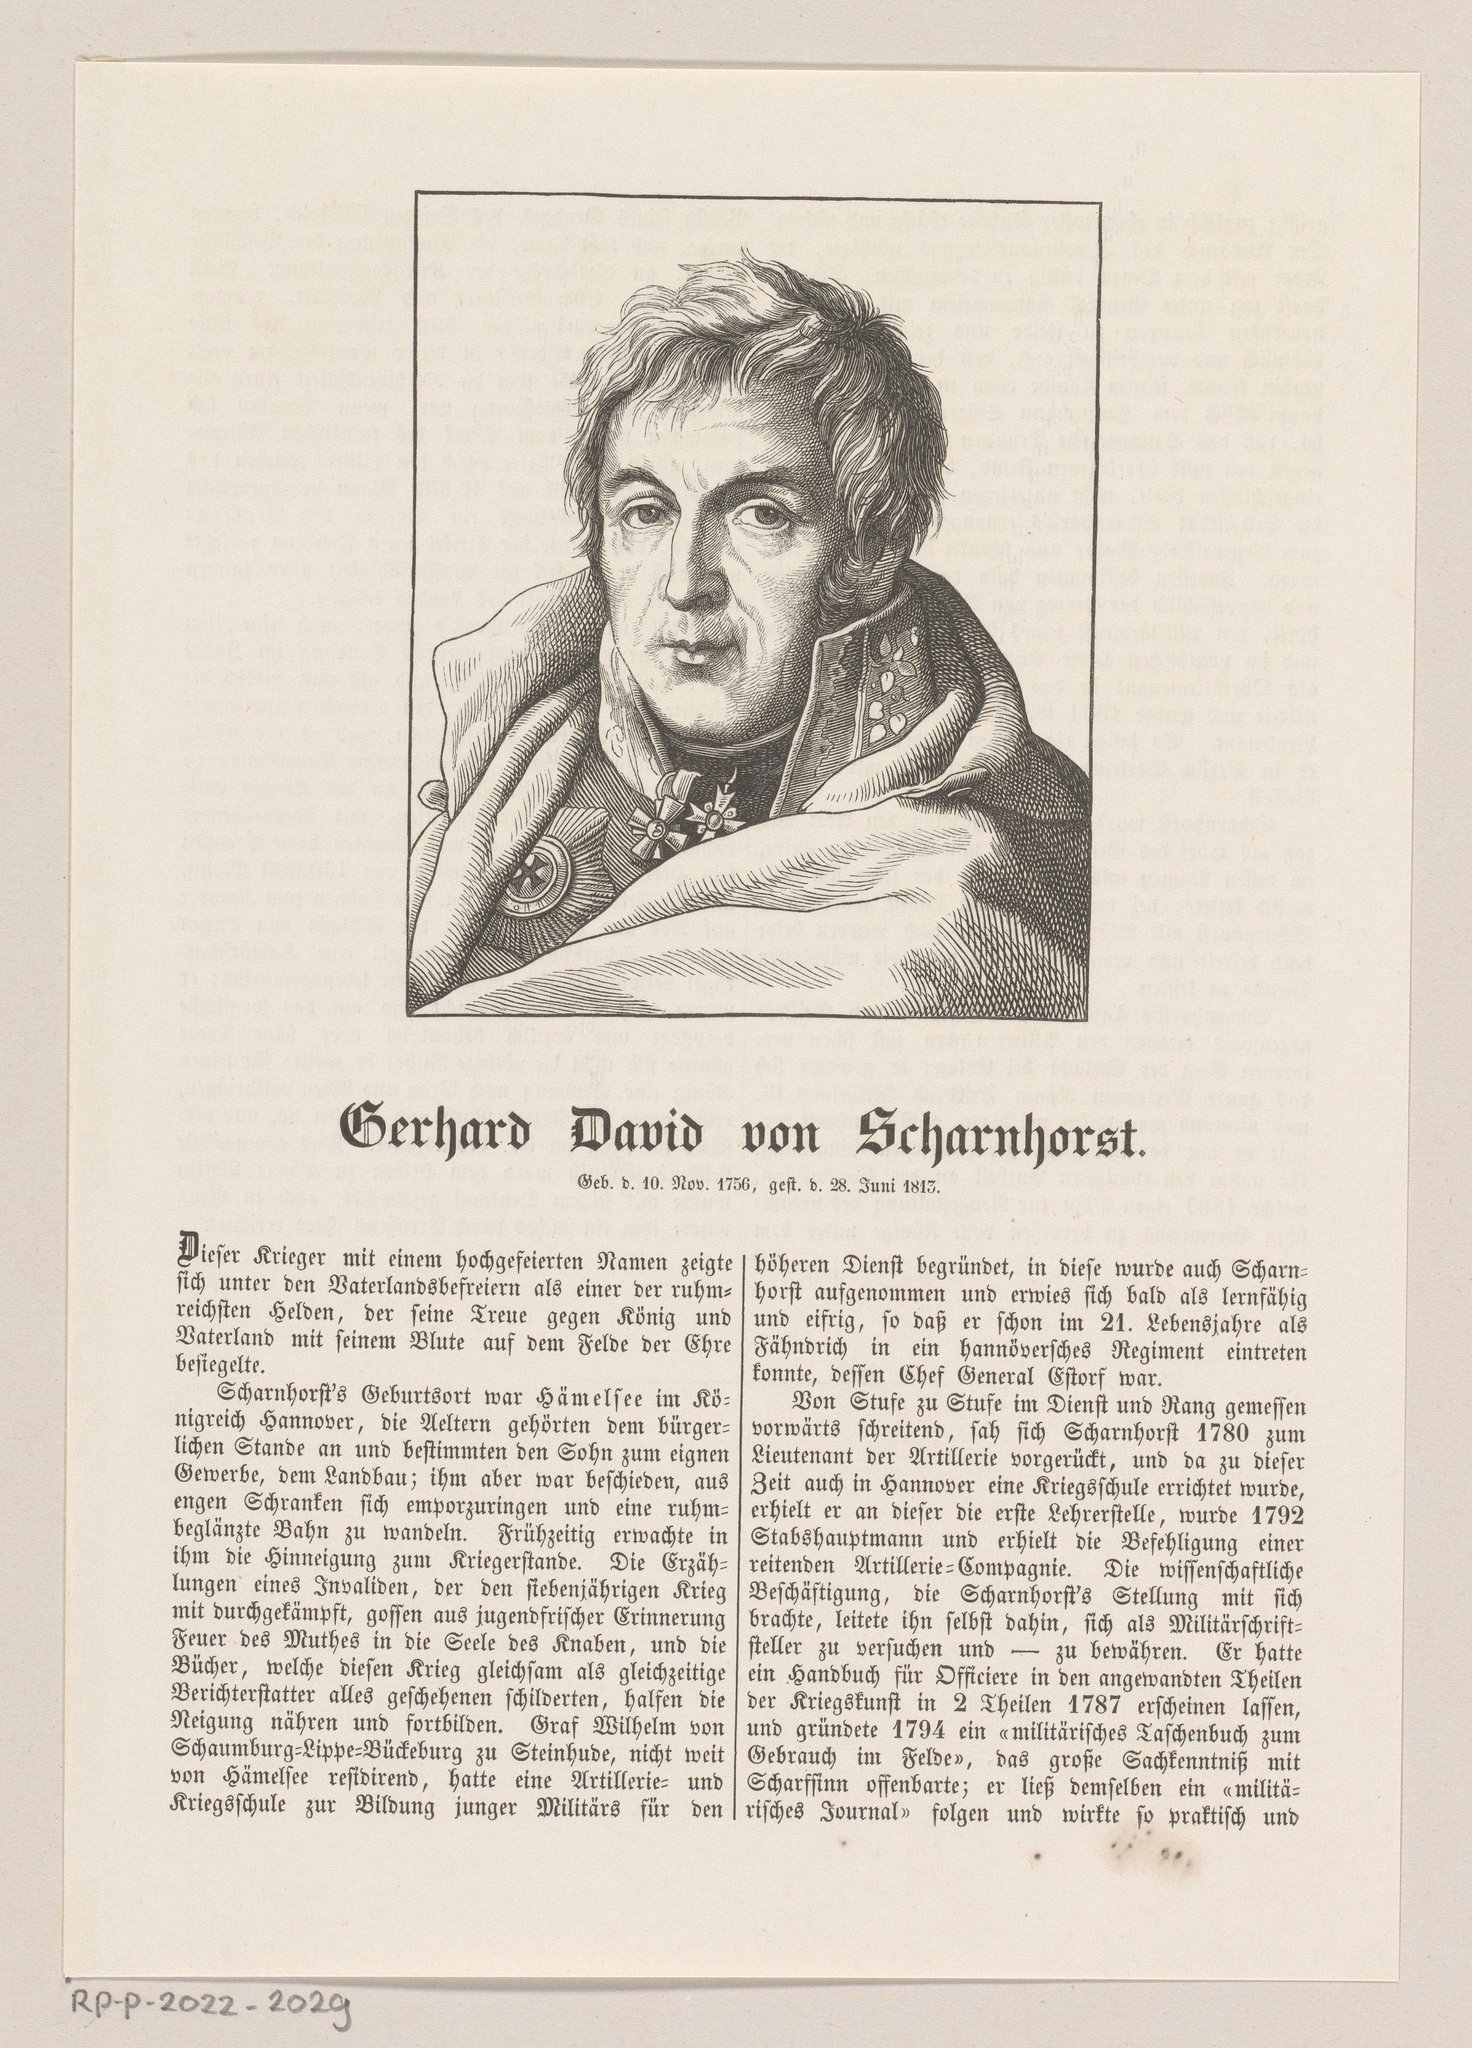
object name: book illustration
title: Portret van Gerhard von Scharnhorst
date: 1854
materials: paper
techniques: letterpress printing, engraving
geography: leipzig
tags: prague, knighthood order, commander-in-chief, general, marshal, historical persons, (military) uniforms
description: Bladzijde uit: Bechstein, Ludwig. Zweihundert deutsche Männer in Bildnissen und Lebensbeschreibungen. Leipzig: Georg Wigand, 1854. Prent met andere tekst gebruikt in: Gaedertz, Karl Theodor. Dreihundert Bildnisse und Lebensabrisse berühmter deutscher Männer. Leipzig: Georg Wigand, 1890. Bij de uitgave uit 1890 staat op de titelpagina vermeld dat de prenten zijn gemaakt door Hugo Bürkner.